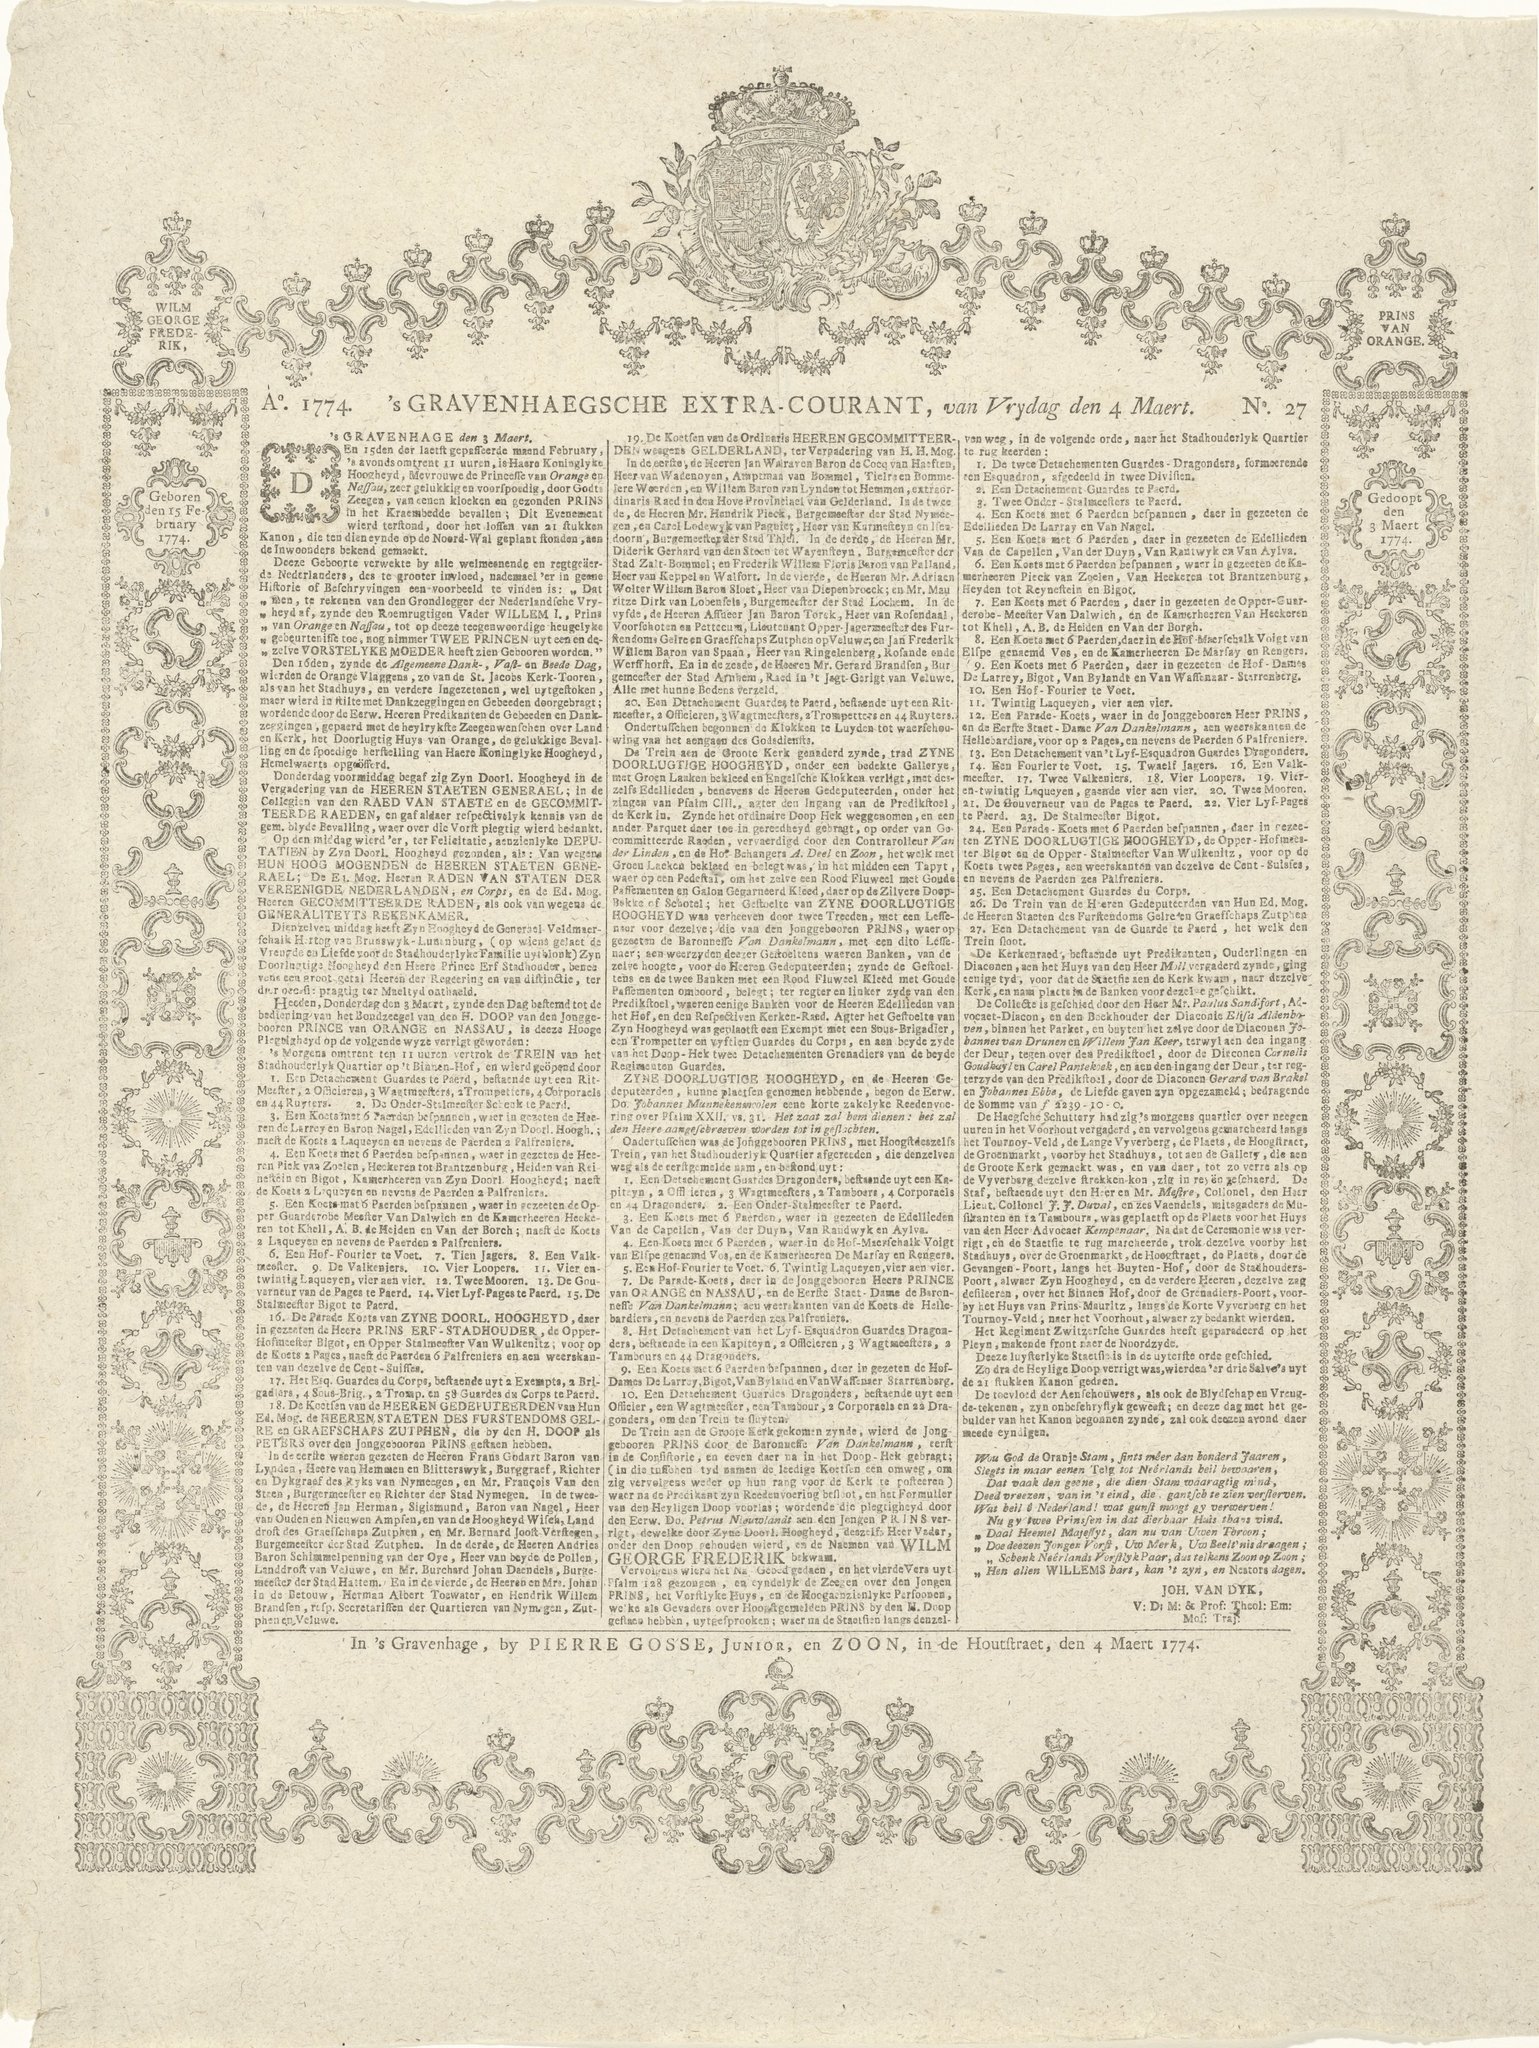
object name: print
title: 's Gravenhaegse Extra Courant van 4 maart 1774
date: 1774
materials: paper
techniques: woodcut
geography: the hague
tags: willem george frederik (prins van oranje-nassau)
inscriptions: collector's mark: Lugt 2228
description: Aflevering nr. 27 van de 's Gravenhaegse Extra Courant van 4 maart 1774, naar aanleiding van de doop van prins Willem George Frederik op 3 maart te Den Haag. Blad met drie kolommen tekst in een ornamentale rand van fileten. Bovenaan een vignet met de gekroonde wapens van de prins en prinses.